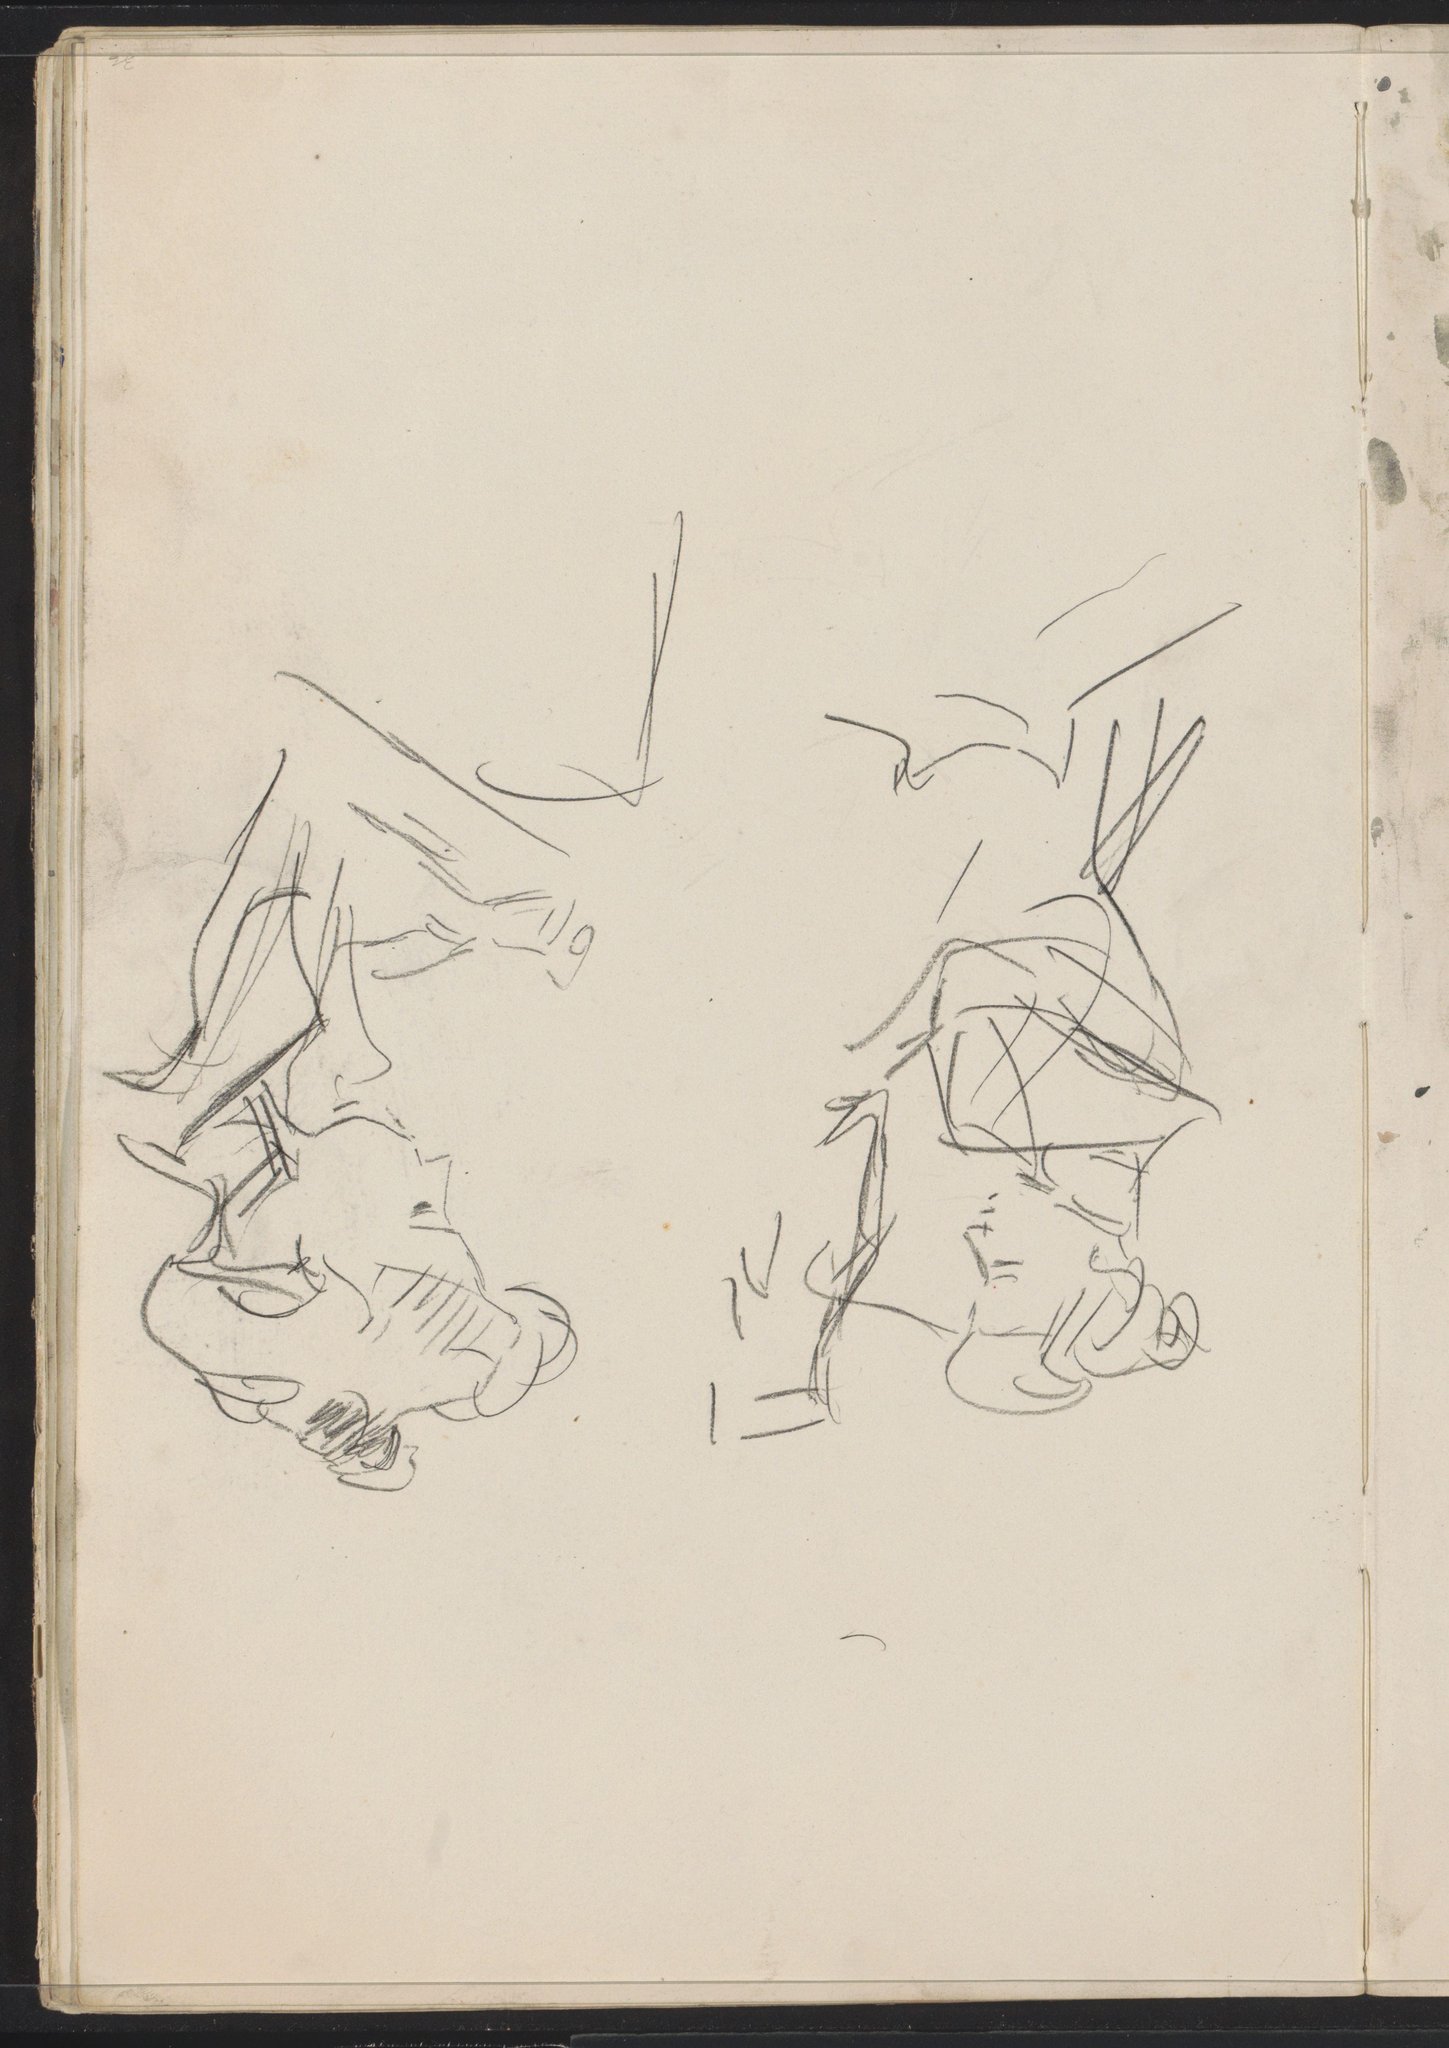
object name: sketchbook leaf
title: Twee jonge vrouwen aan het werk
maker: isaac israels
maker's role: draughtsman, painter, print maker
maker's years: 1865-1934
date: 1875-1934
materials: chalk, paper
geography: the hague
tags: adolescent, young woman, maiden, sewing, working class, labourers - aa - women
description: Mogelijk naaisters. Blad 15 verso uit schetsboek LXIX met 25 bladen.